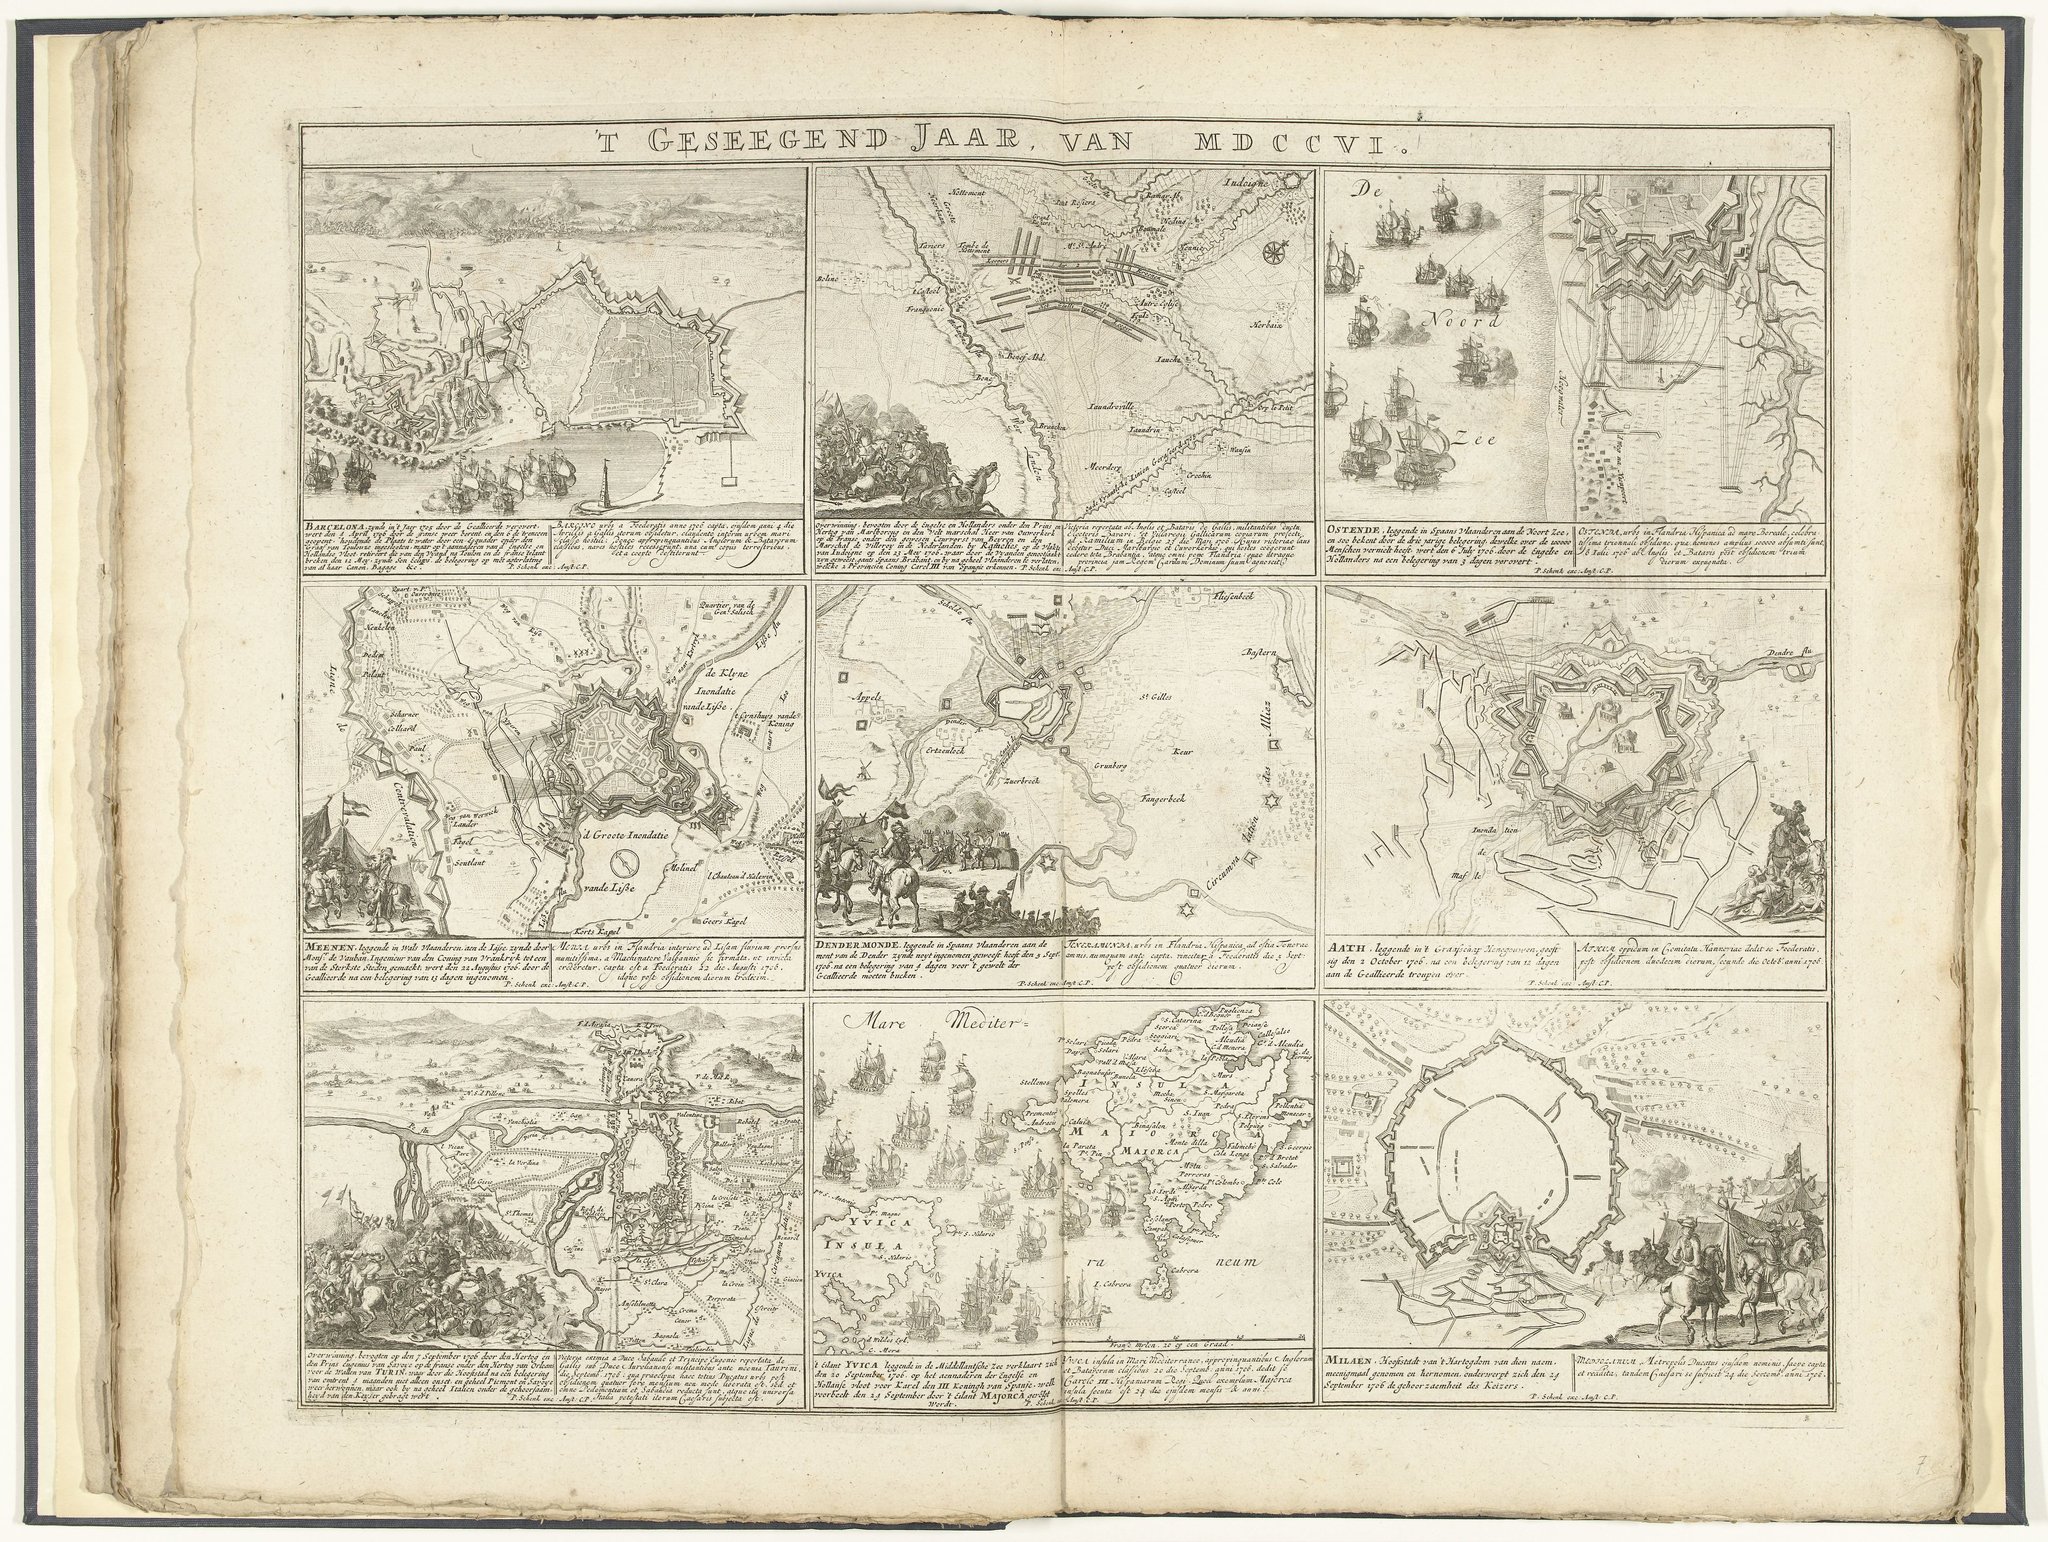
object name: print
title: Schouwtoneel van den oorlog (blad VII), 1706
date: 1706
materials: paper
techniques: etching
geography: amsterdam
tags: fortress, maps of cities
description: Blad met negen voorstellingen van gebeurtenissen uit het jaar 1706 van de Spaanse Successieoorlog en van plattegronden van versterkte steden. Opschriften in de voorstelling in het Nederlands en Latijn. Plaat 6 in het prentwerk met de gebundelde reeks van 33 platen met voorstellingen (het merendeel verdeeld in 9 kleinere scènes) van gebeurtenissen uit de jaren 1700-1727 van de Spaanse Successieoorlog en de jaren daarna, kaarten en plattegronden.